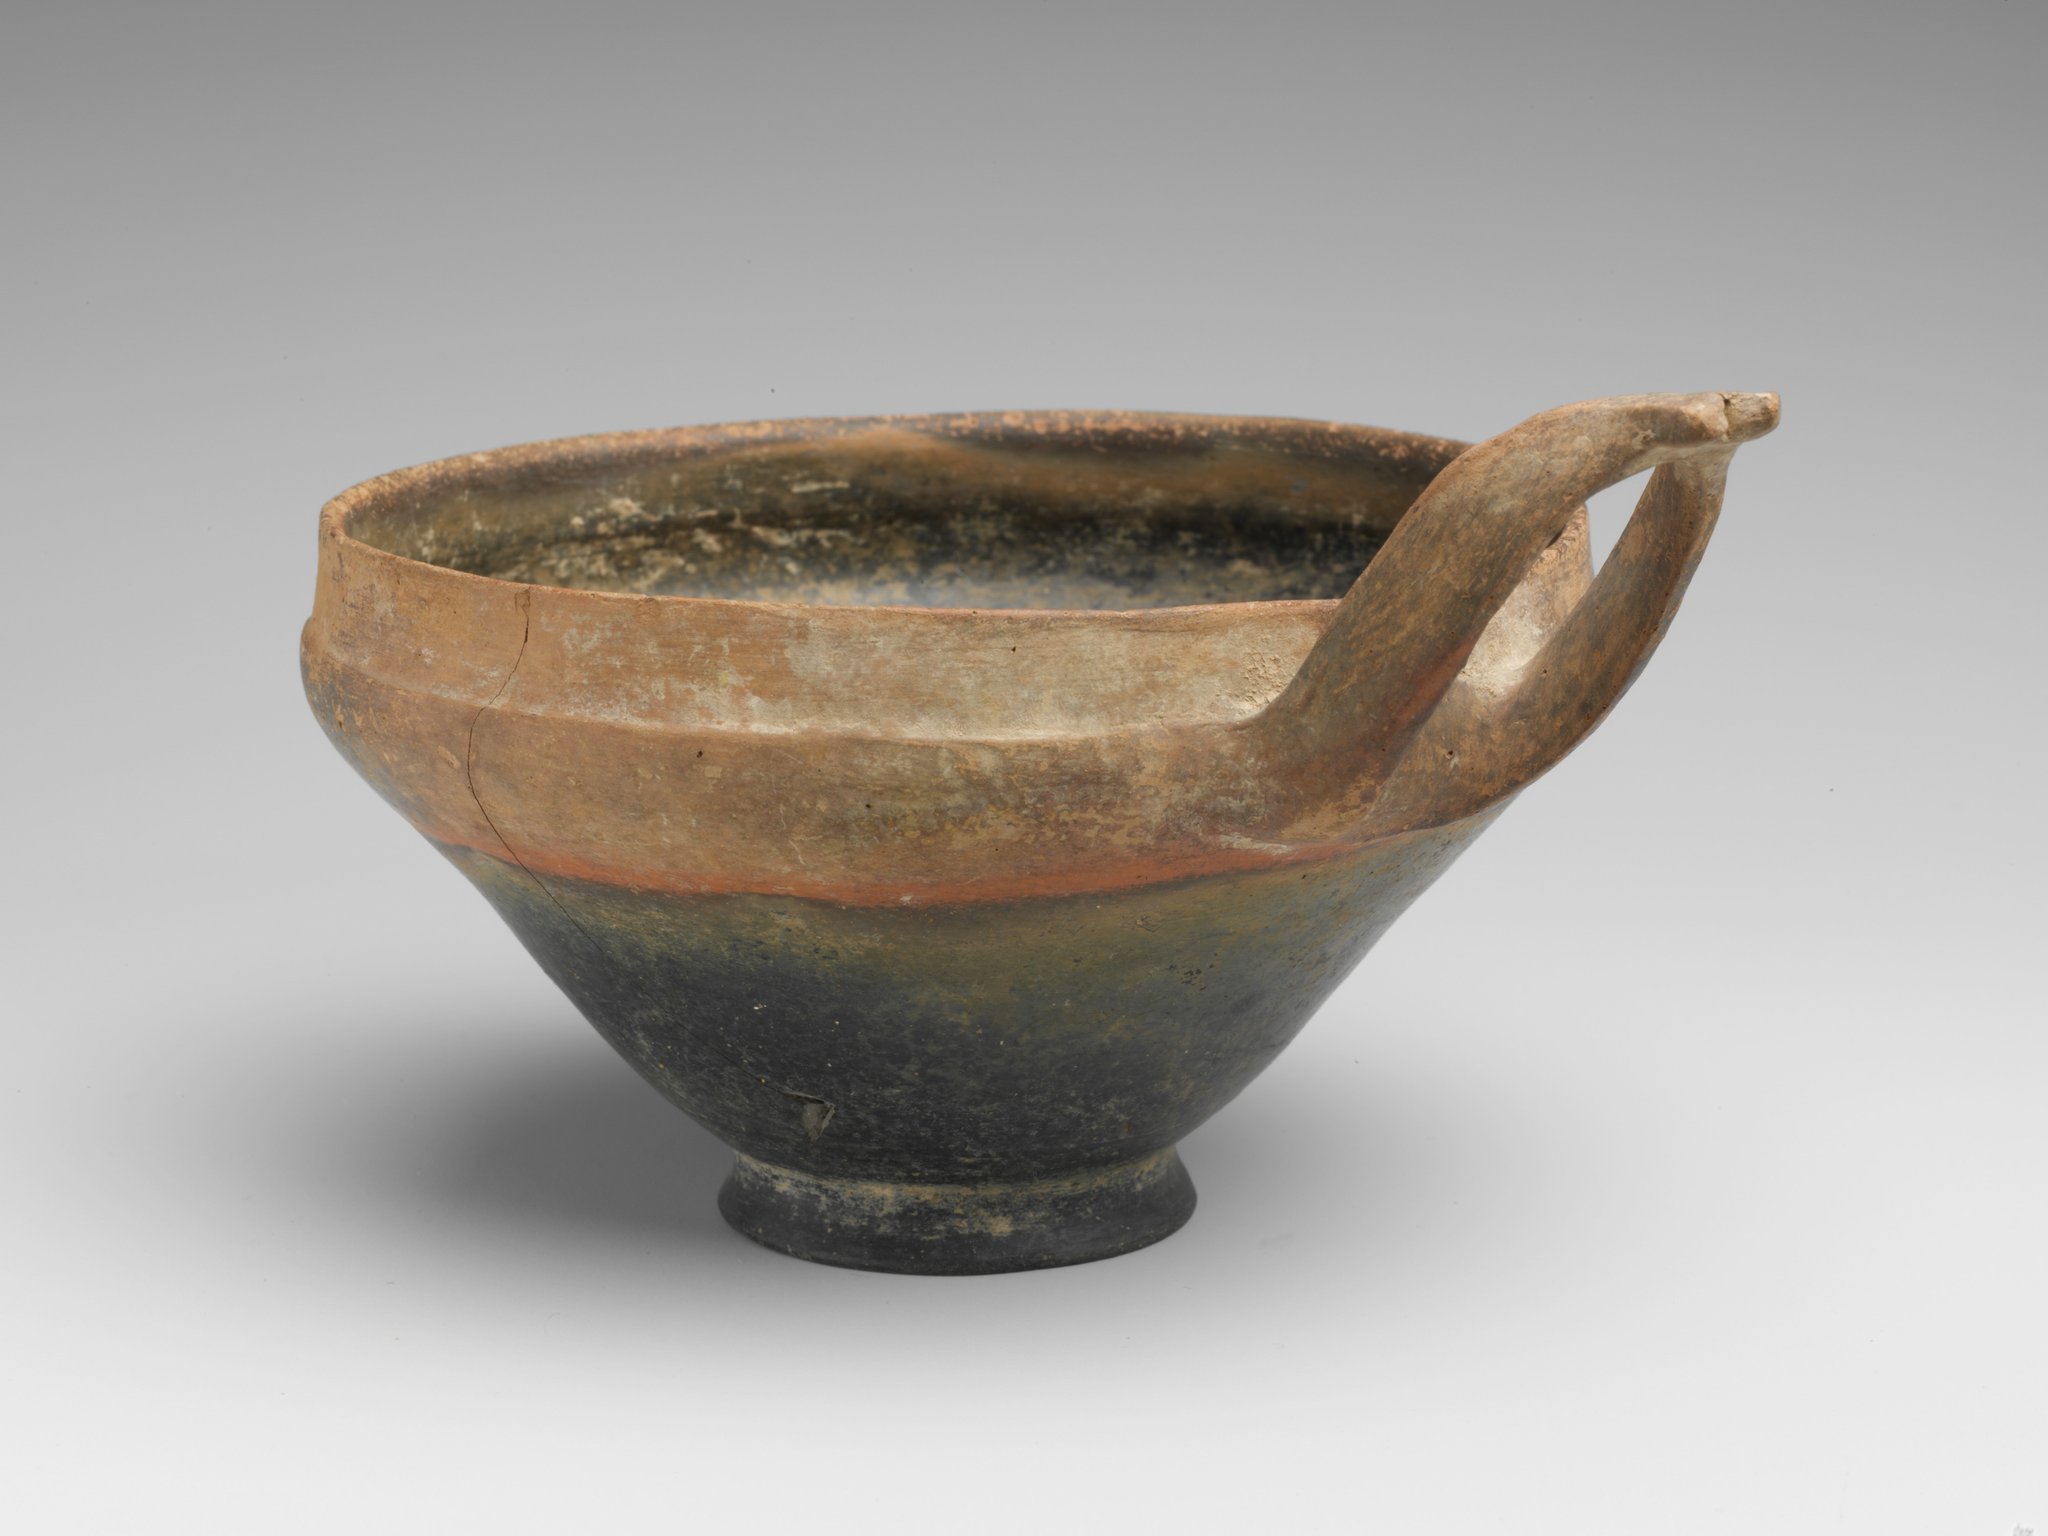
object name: bowl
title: Terracotta bowl with wishbone handle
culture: cypriot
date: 1600-1200 BCE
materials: terracotta